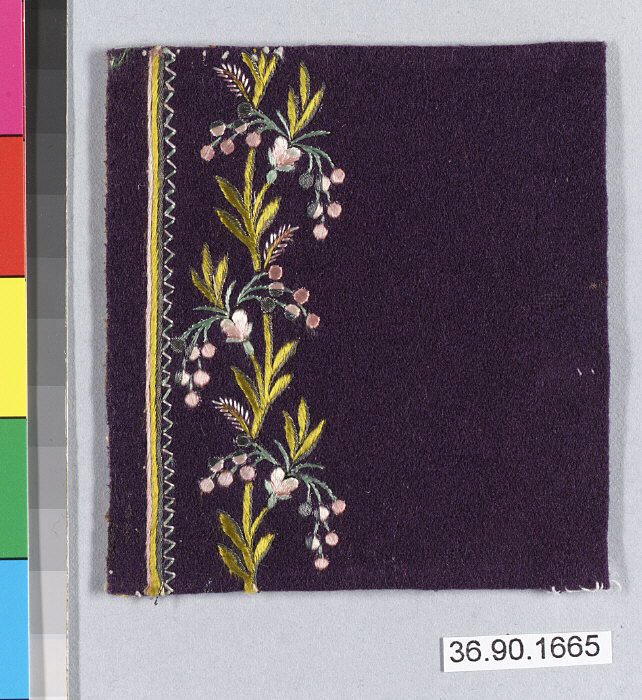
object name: sample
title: Embroidery sample for a man’s suit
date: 1785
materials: metal thread, silk, wool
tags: flowers